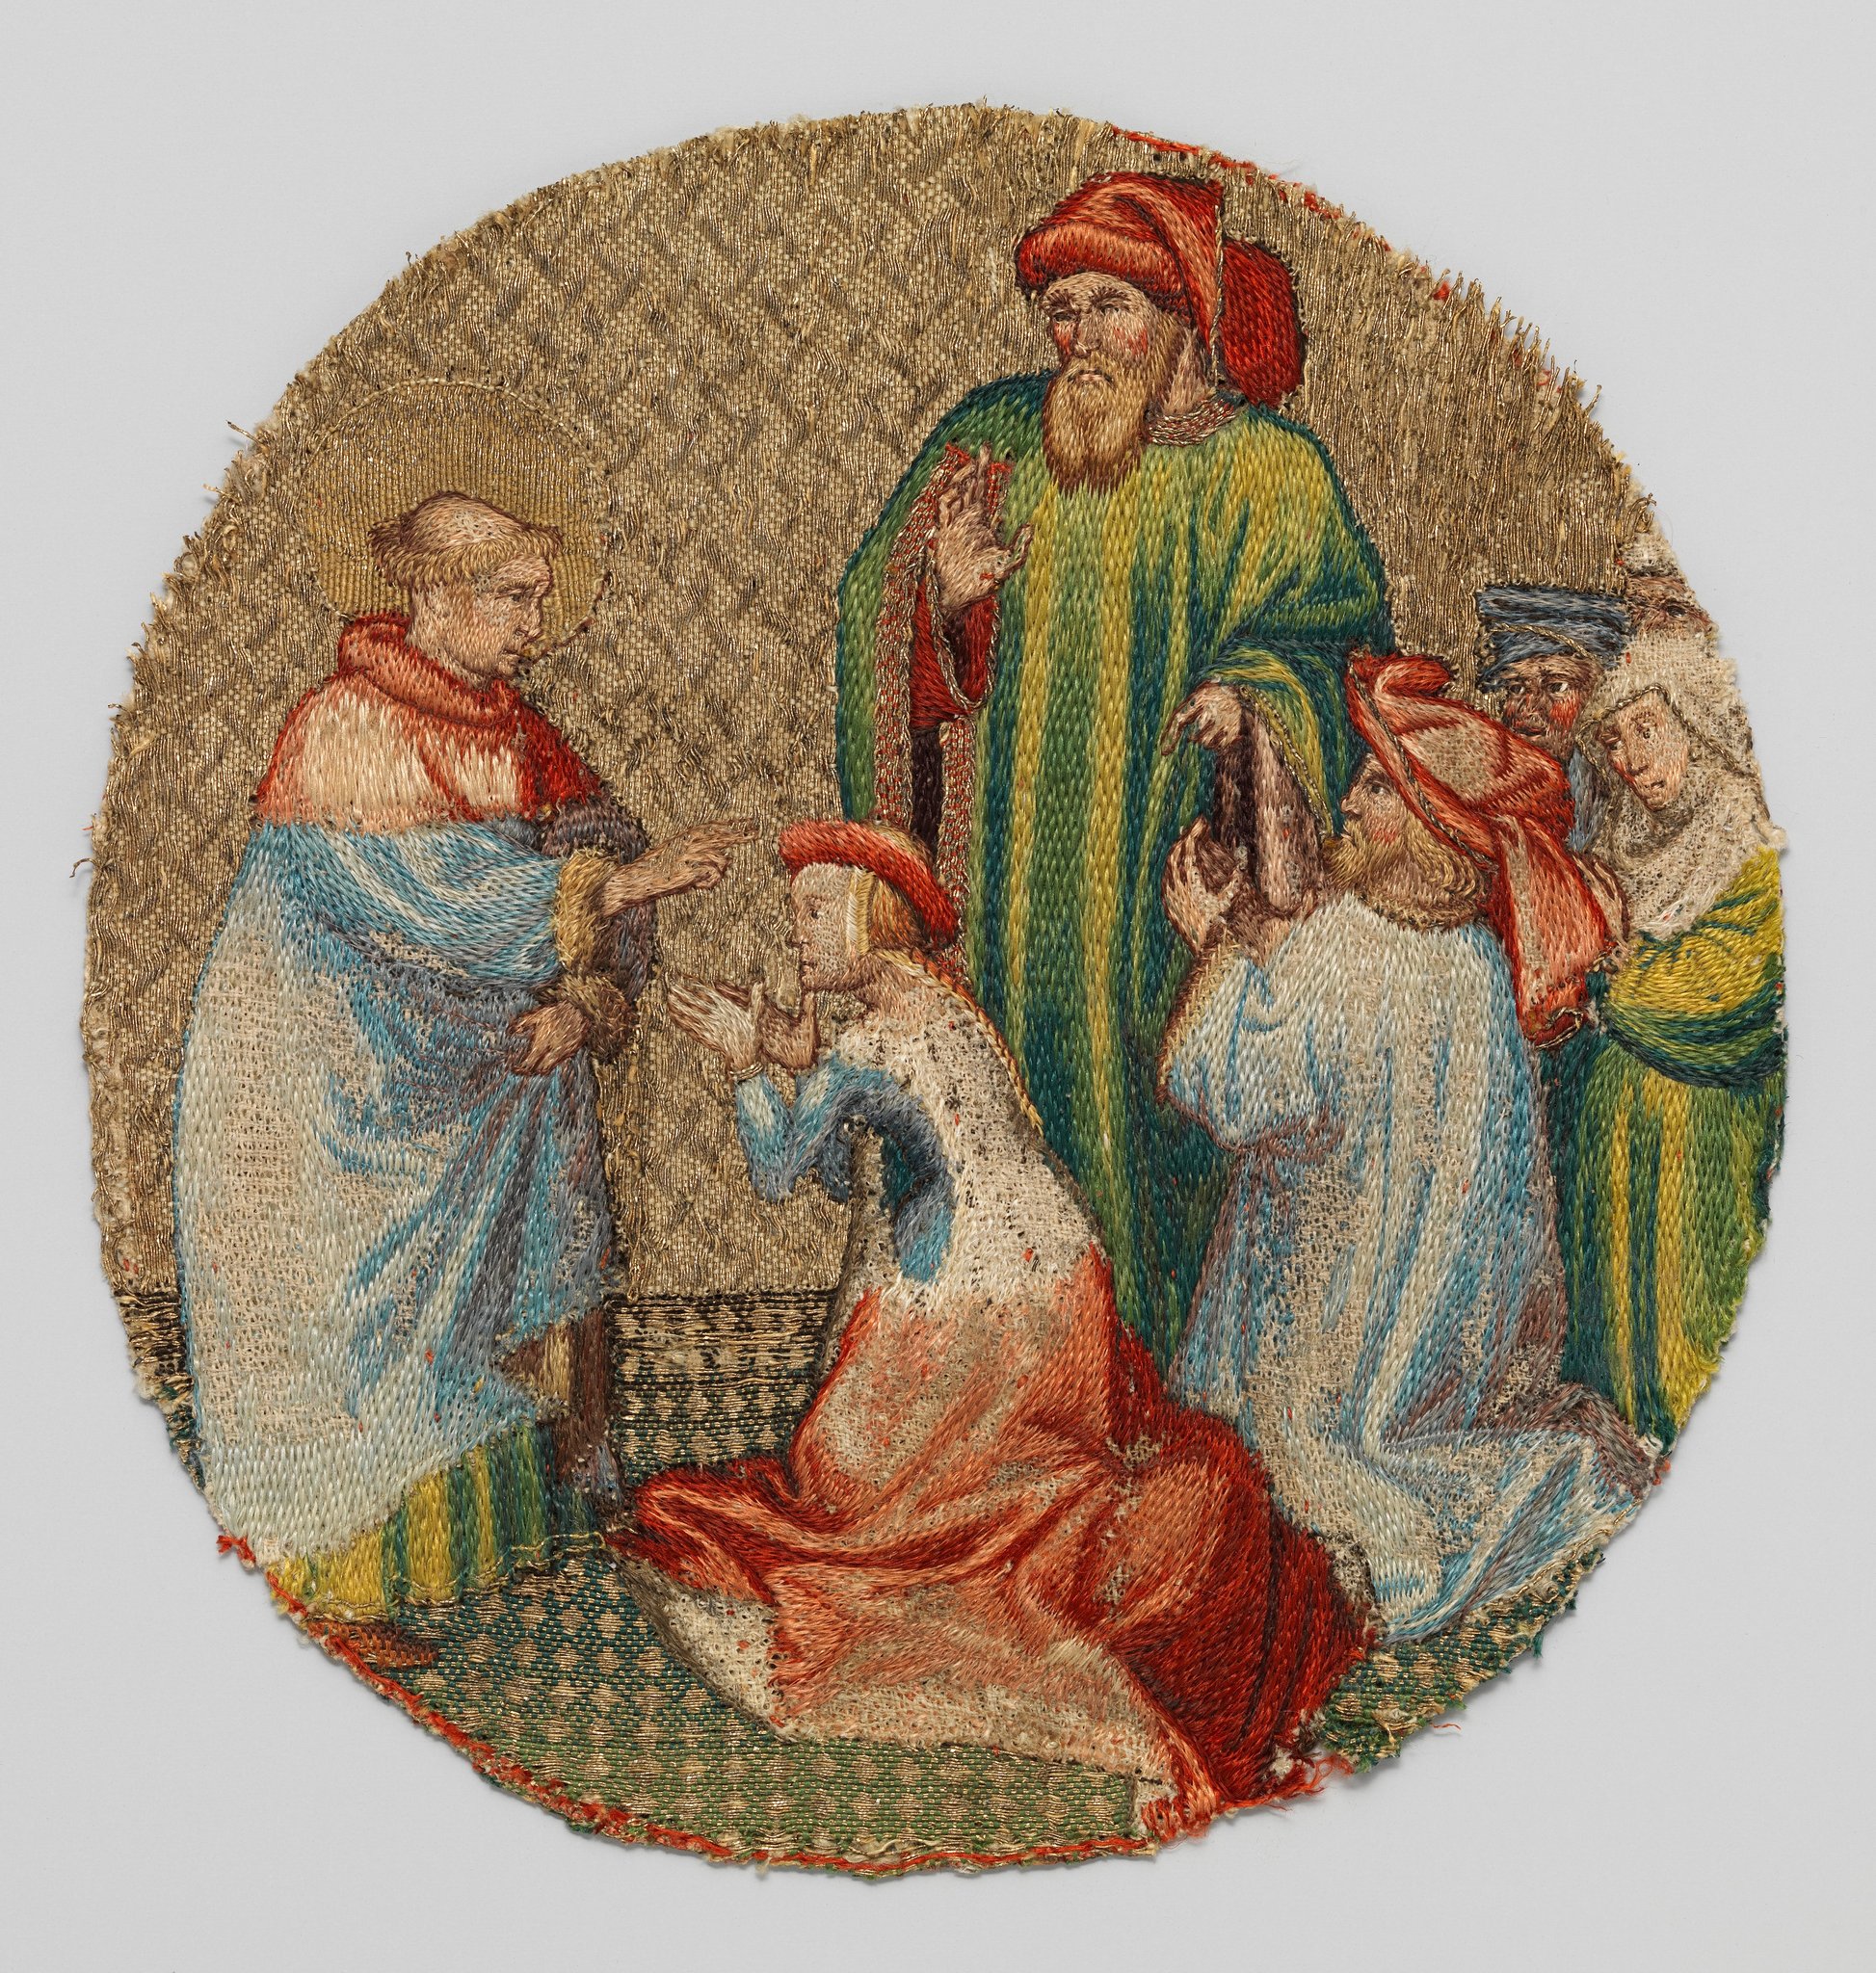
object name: roundel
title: The Empress Kneels Before Saint Martin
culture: south netherlandish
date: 1430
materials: linen, metal thread, silk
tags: men,women,saints